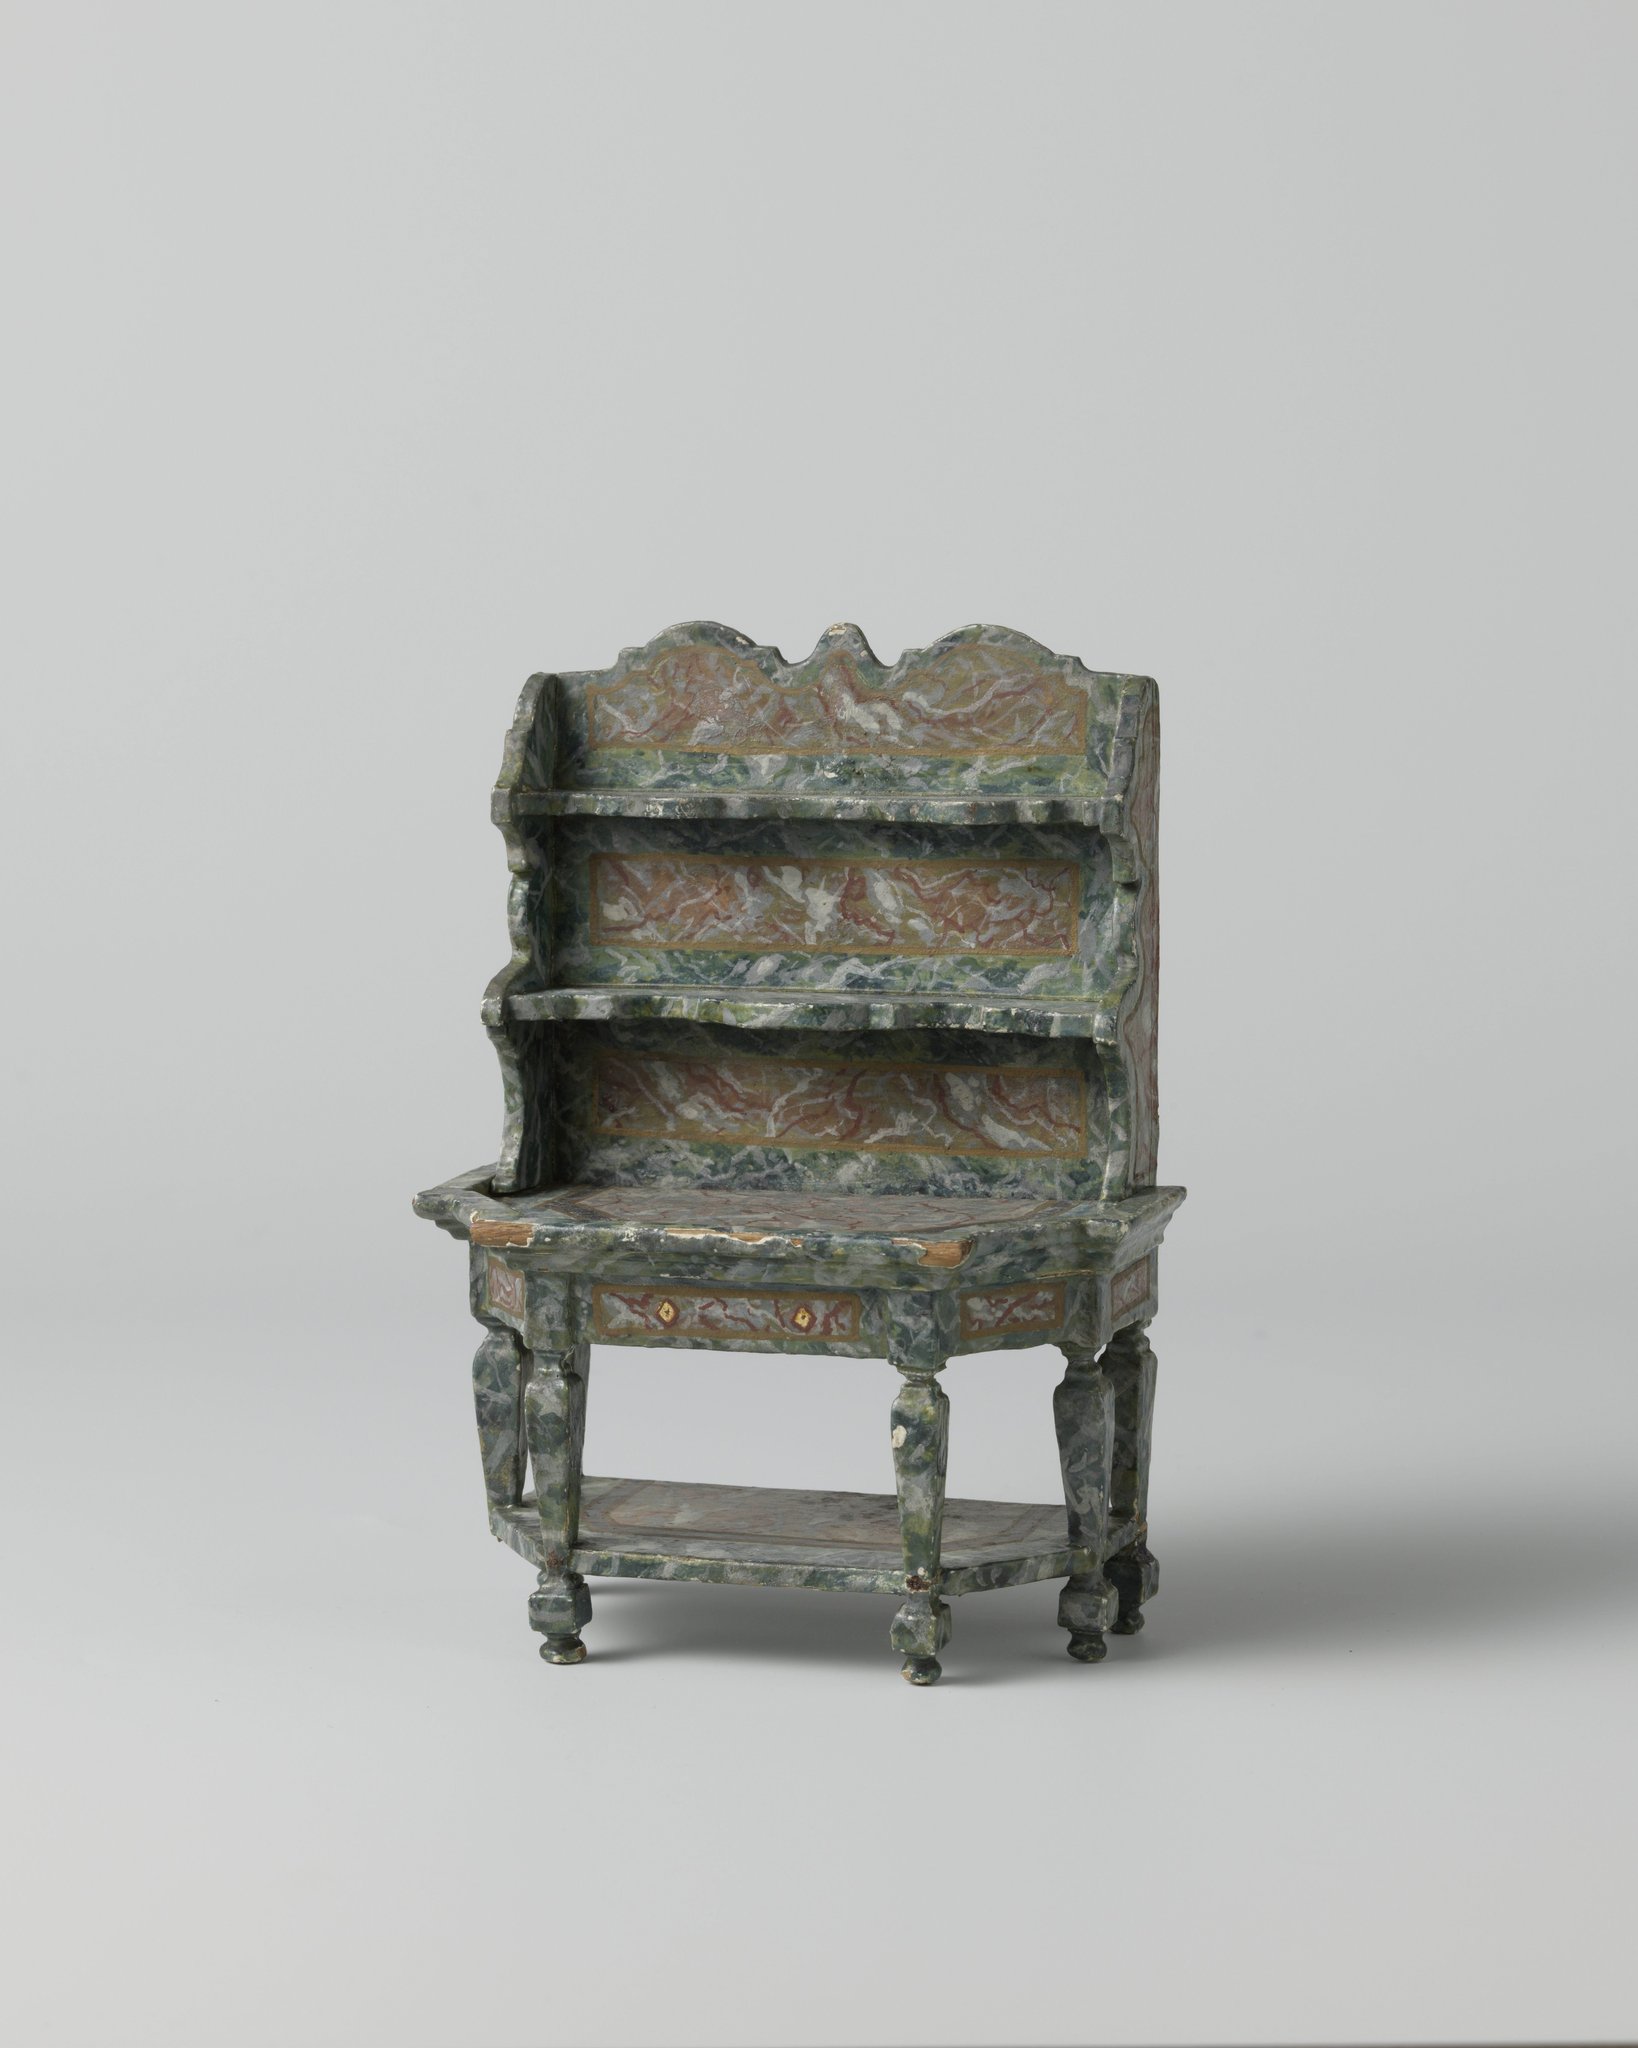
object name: buffet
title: Buffet, gemarmerd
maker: Anonymous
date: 1700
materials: wood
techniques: painted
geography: amsterdam